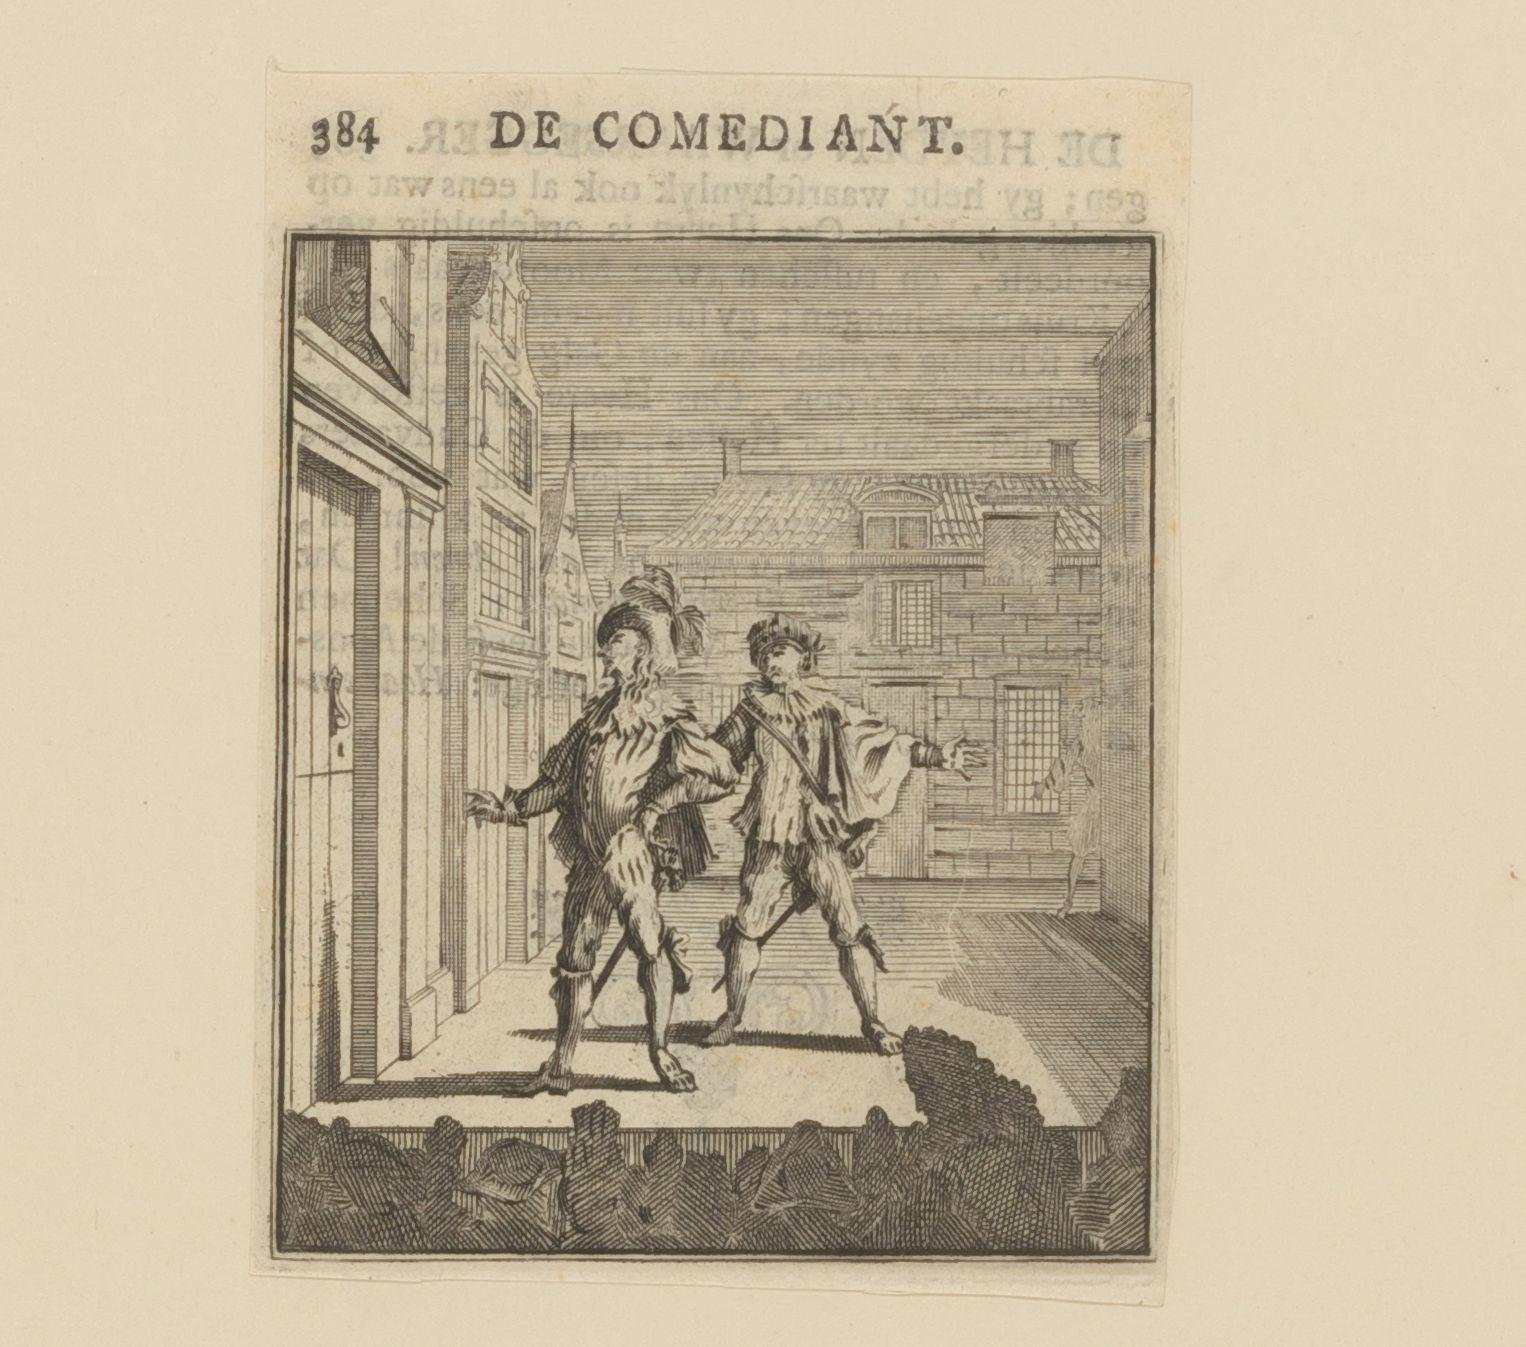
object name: print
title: De Comediant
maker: Anonymous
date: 1719-1759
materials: paper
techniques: etching, letterpress printing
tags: comedy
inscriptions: collector's mark: Lugt 1641, stamp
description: Prent met andere letterzetting gebruikt in: St. Clara, Abraham van. Iets voor allen. [Vertaald door] J. le Long. Amsterdam: Janssoons van Waesberge, 1719, dl. 2. En in: St. Clara, Abraham van. Iets voor allen. [Vertaald door] J. le Long. Amsterdam: Jan Roman de Jonge, 1741, dl. 2. En in: St. Clara, Abraham van. Iets voor allen. [Vertaald door] J. le Long. Amsterdam: Jan Roman, 1759, dl. 2. Huidige prent uit een andere editie. Naar een prent van: Jan Luyken.